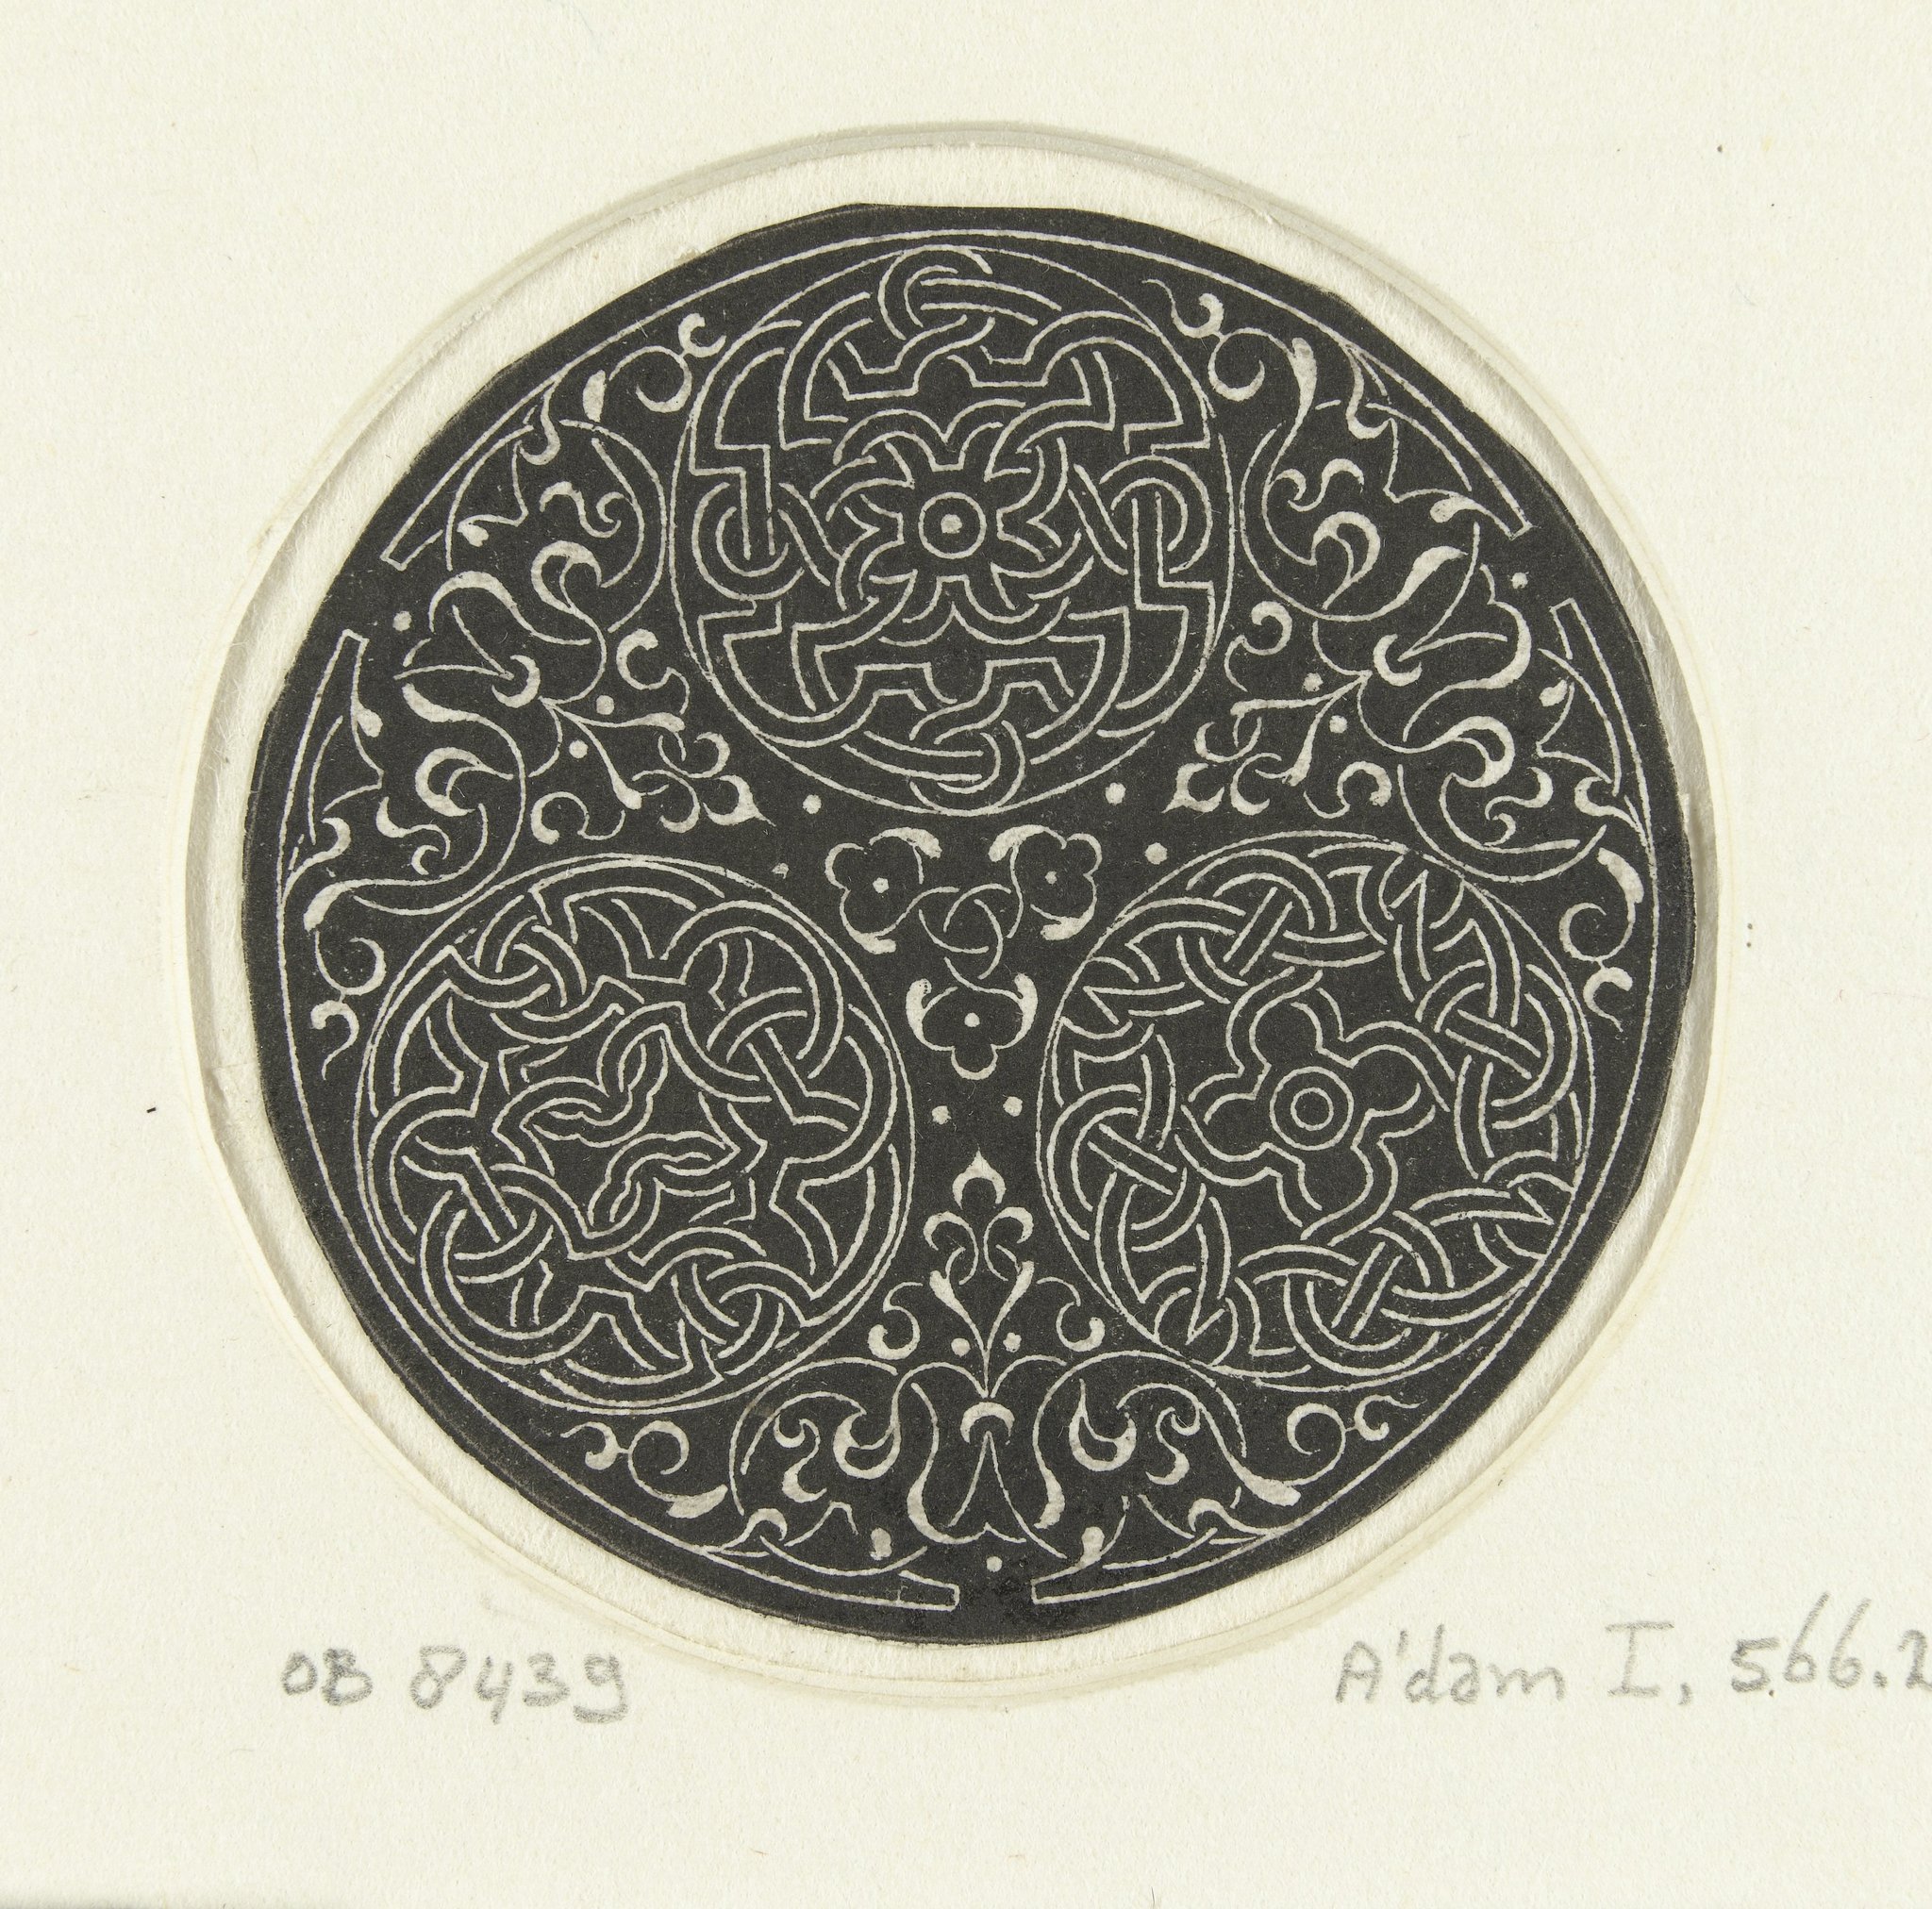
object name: ornament print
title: Drie medaillons met moresken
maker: Anonymous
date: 1506-1551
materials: paper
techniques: woodcut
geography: france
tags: mirror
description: De medaillons zijn omgeven door arabesken. Uit serie van 9 bladen?